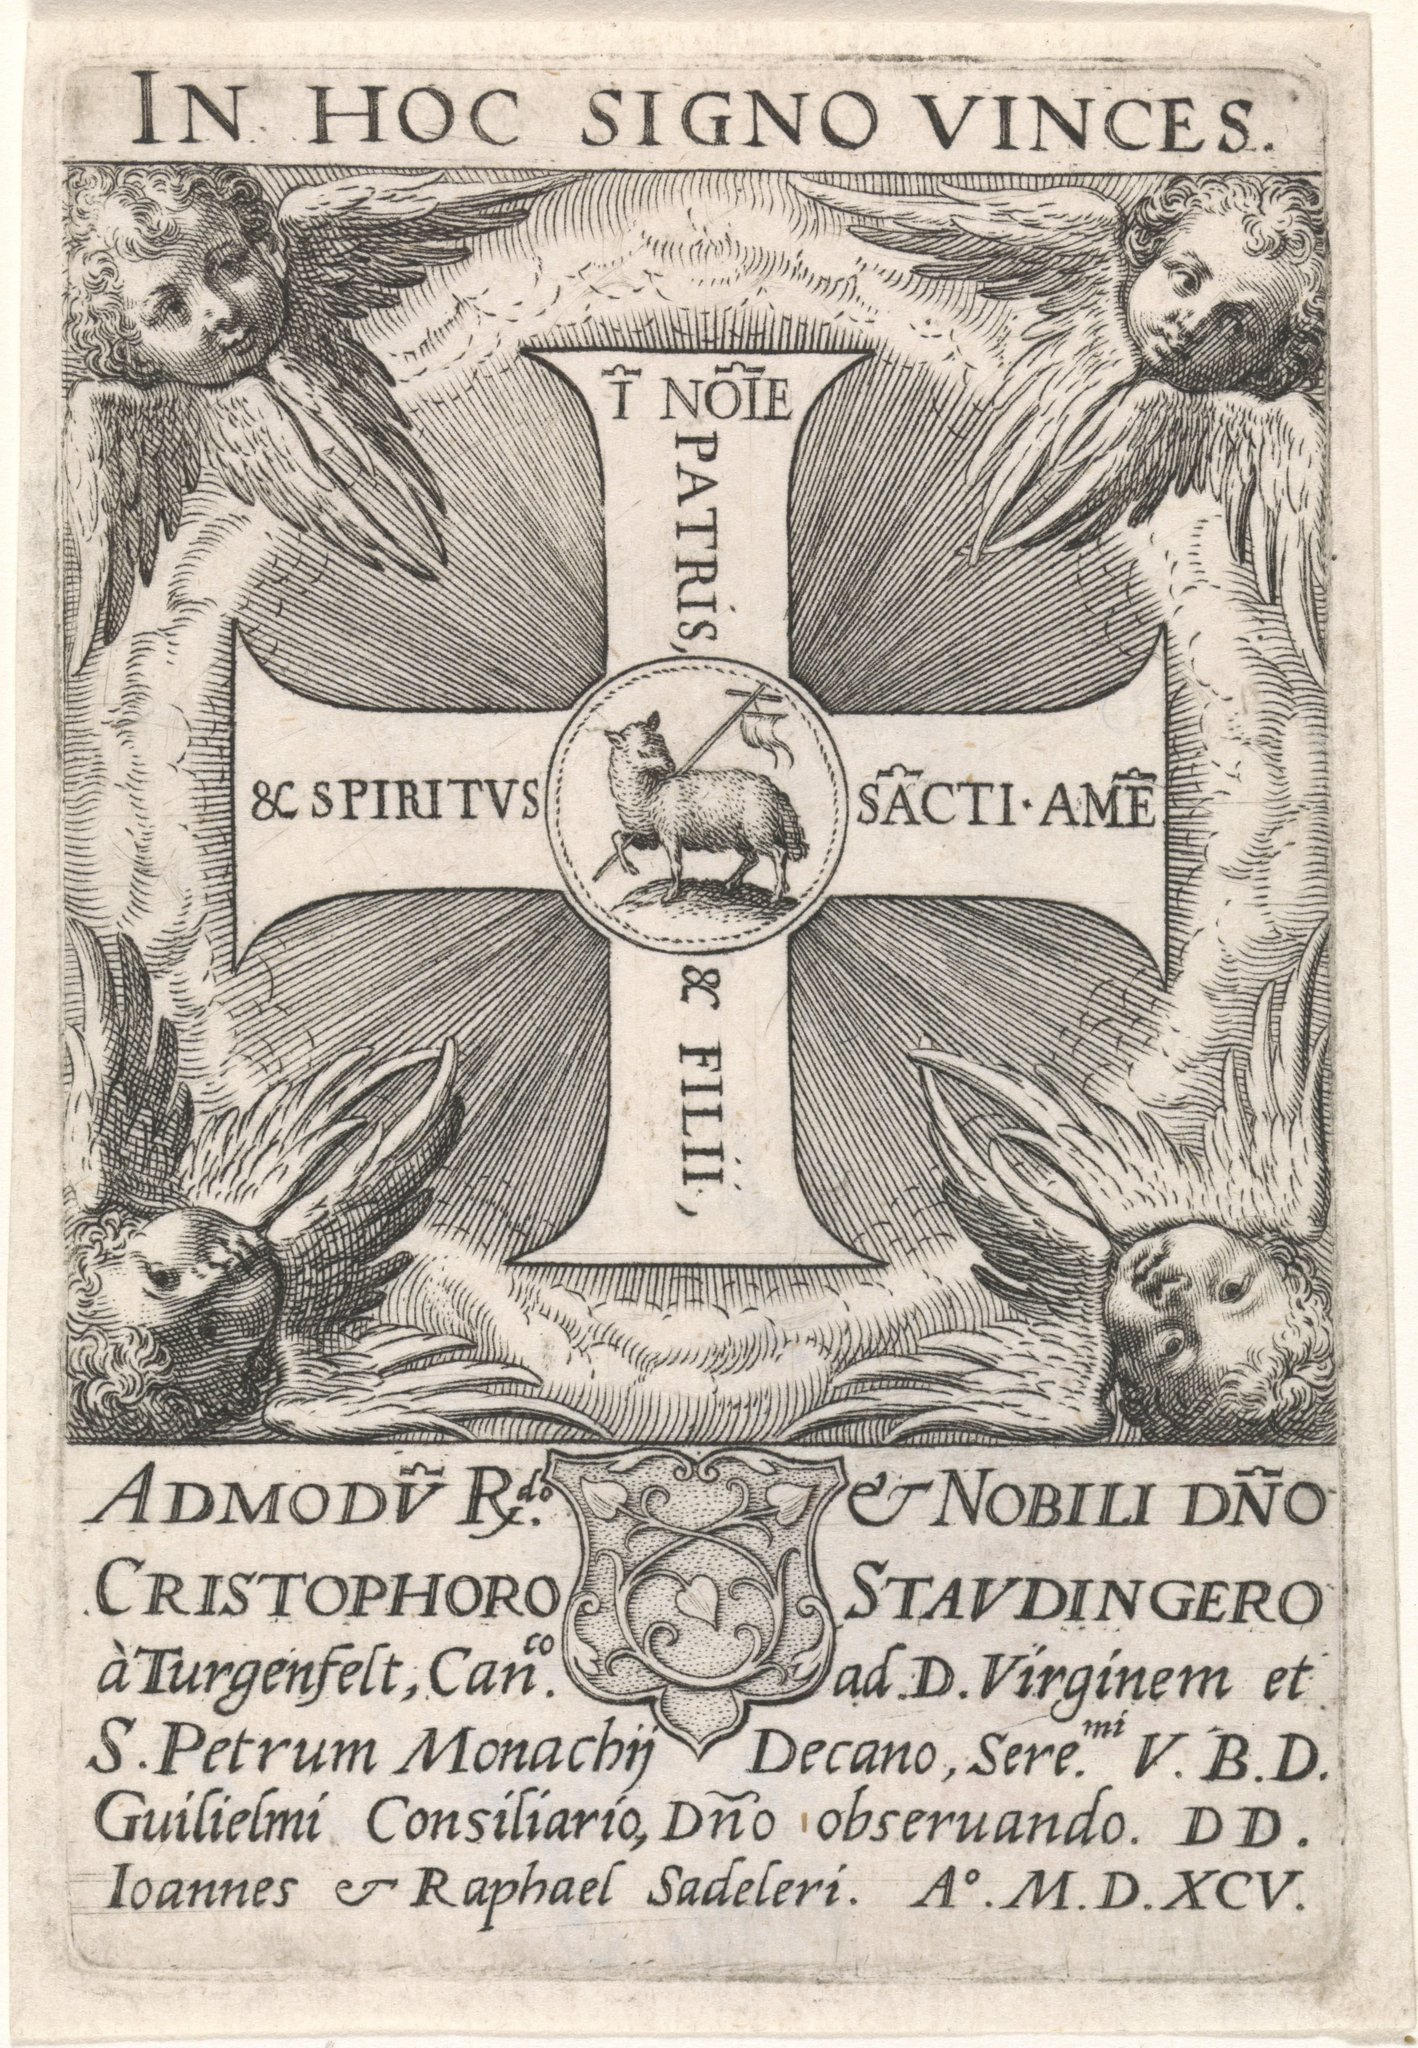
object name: print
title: Kruis met het Lam Gods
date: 1595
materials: paper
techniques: engraving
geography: munich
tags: cross with symbol of christ on it, e.g. lamb, seraphim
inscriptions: collector's mark: Lugt 240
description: Een kruis met in het midden het Lam Gods. In elke hoek een serafijn.